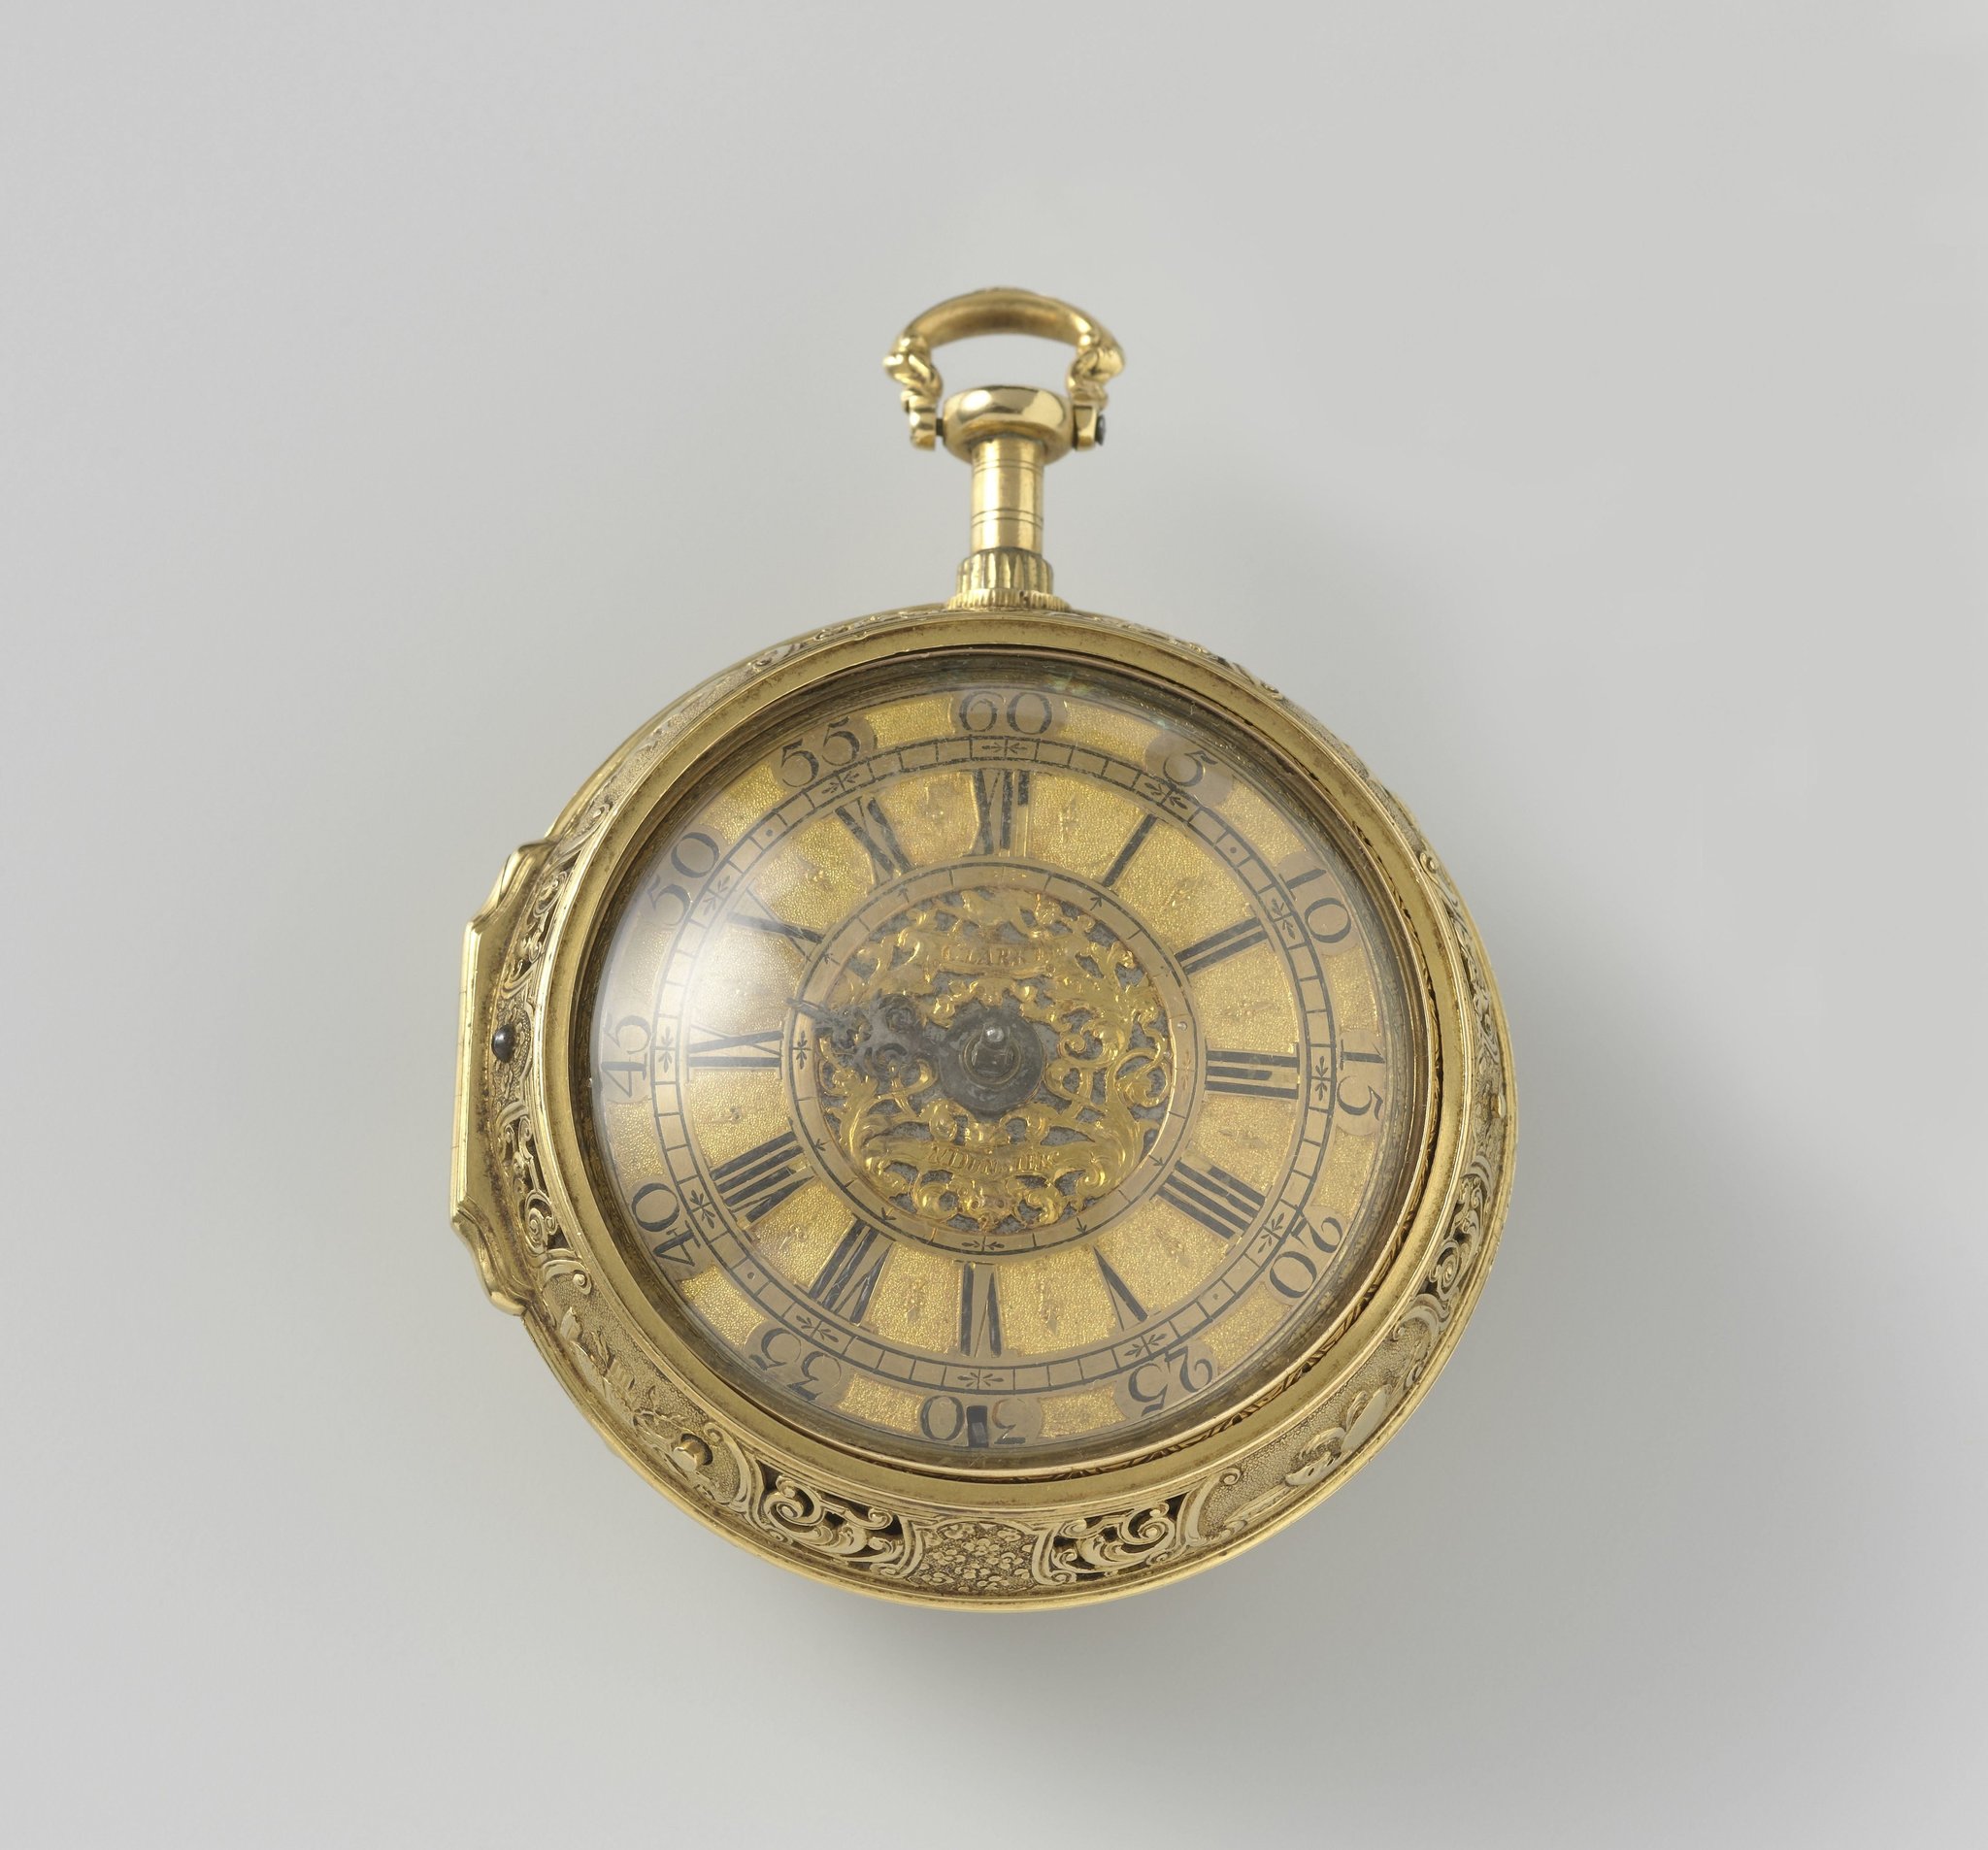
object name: pocket watch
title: Repeating Watch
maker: thauvet beslay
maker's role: jeweler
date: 1725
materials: gold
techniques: repoussé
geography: amsterdam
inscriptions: maker's mark: ‘TB aaneen’, alloy mark: ‘leeuw’, mark: ‘onduidelijk teken’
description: The scene of a company making music may have been the work of an Amsterdam chaser of French origin. Amsterdam craftsmen were specialized in small-scale depictions chased in gold. The maker of the watchcase, Thauvet Beslay, mounted the scene in a gold ajouré, or openwork, outer case. According to the text engraved on the open book, the scene is from Ovid’s guide to the art of love, the Ars Amatoria.